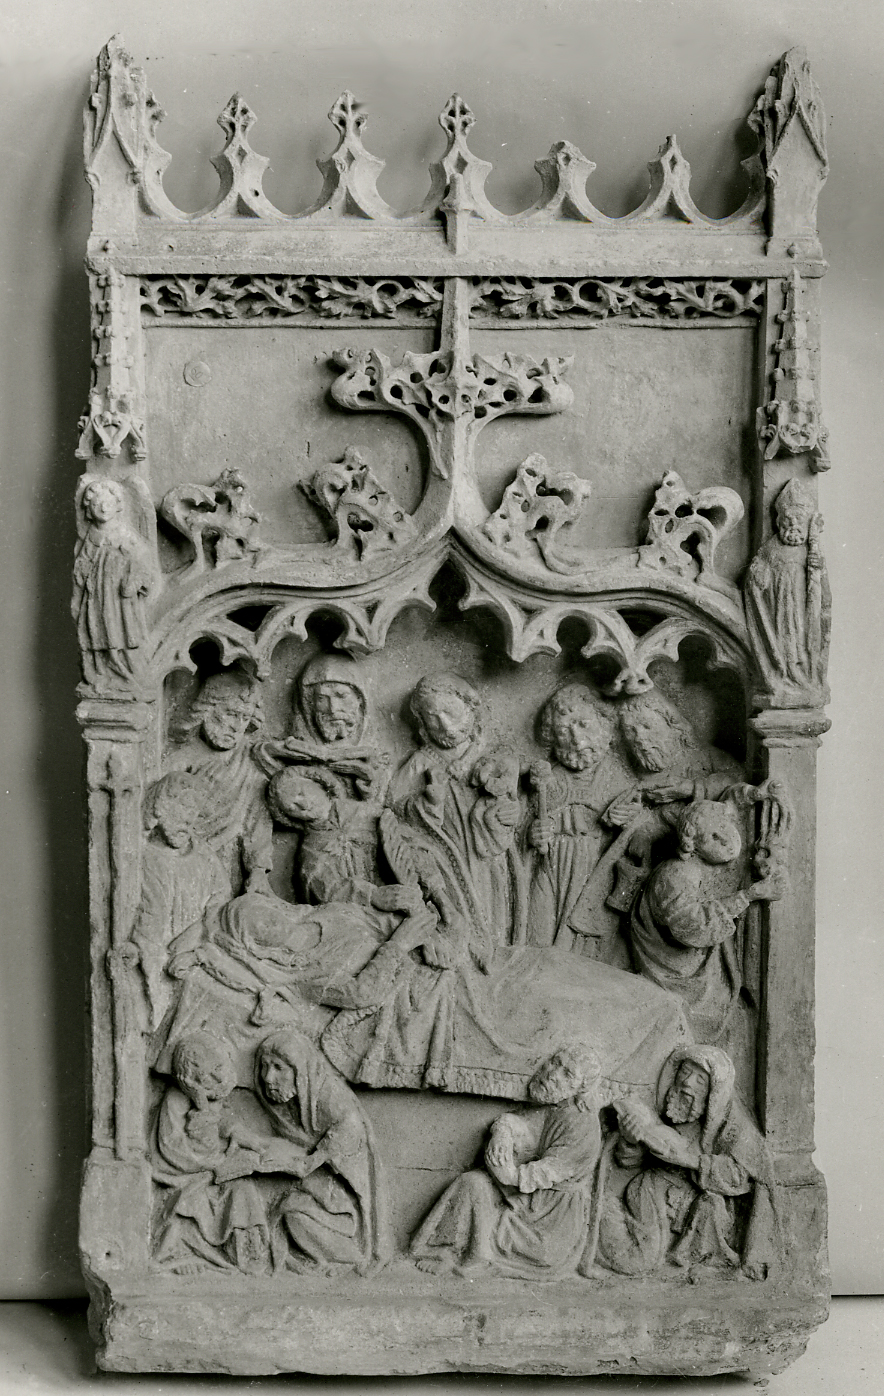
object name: relief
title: Dormition of the Virgin Relief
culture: french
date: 1401-1500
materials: gilt, paint, stone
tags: sadness,men,virgin mary,death